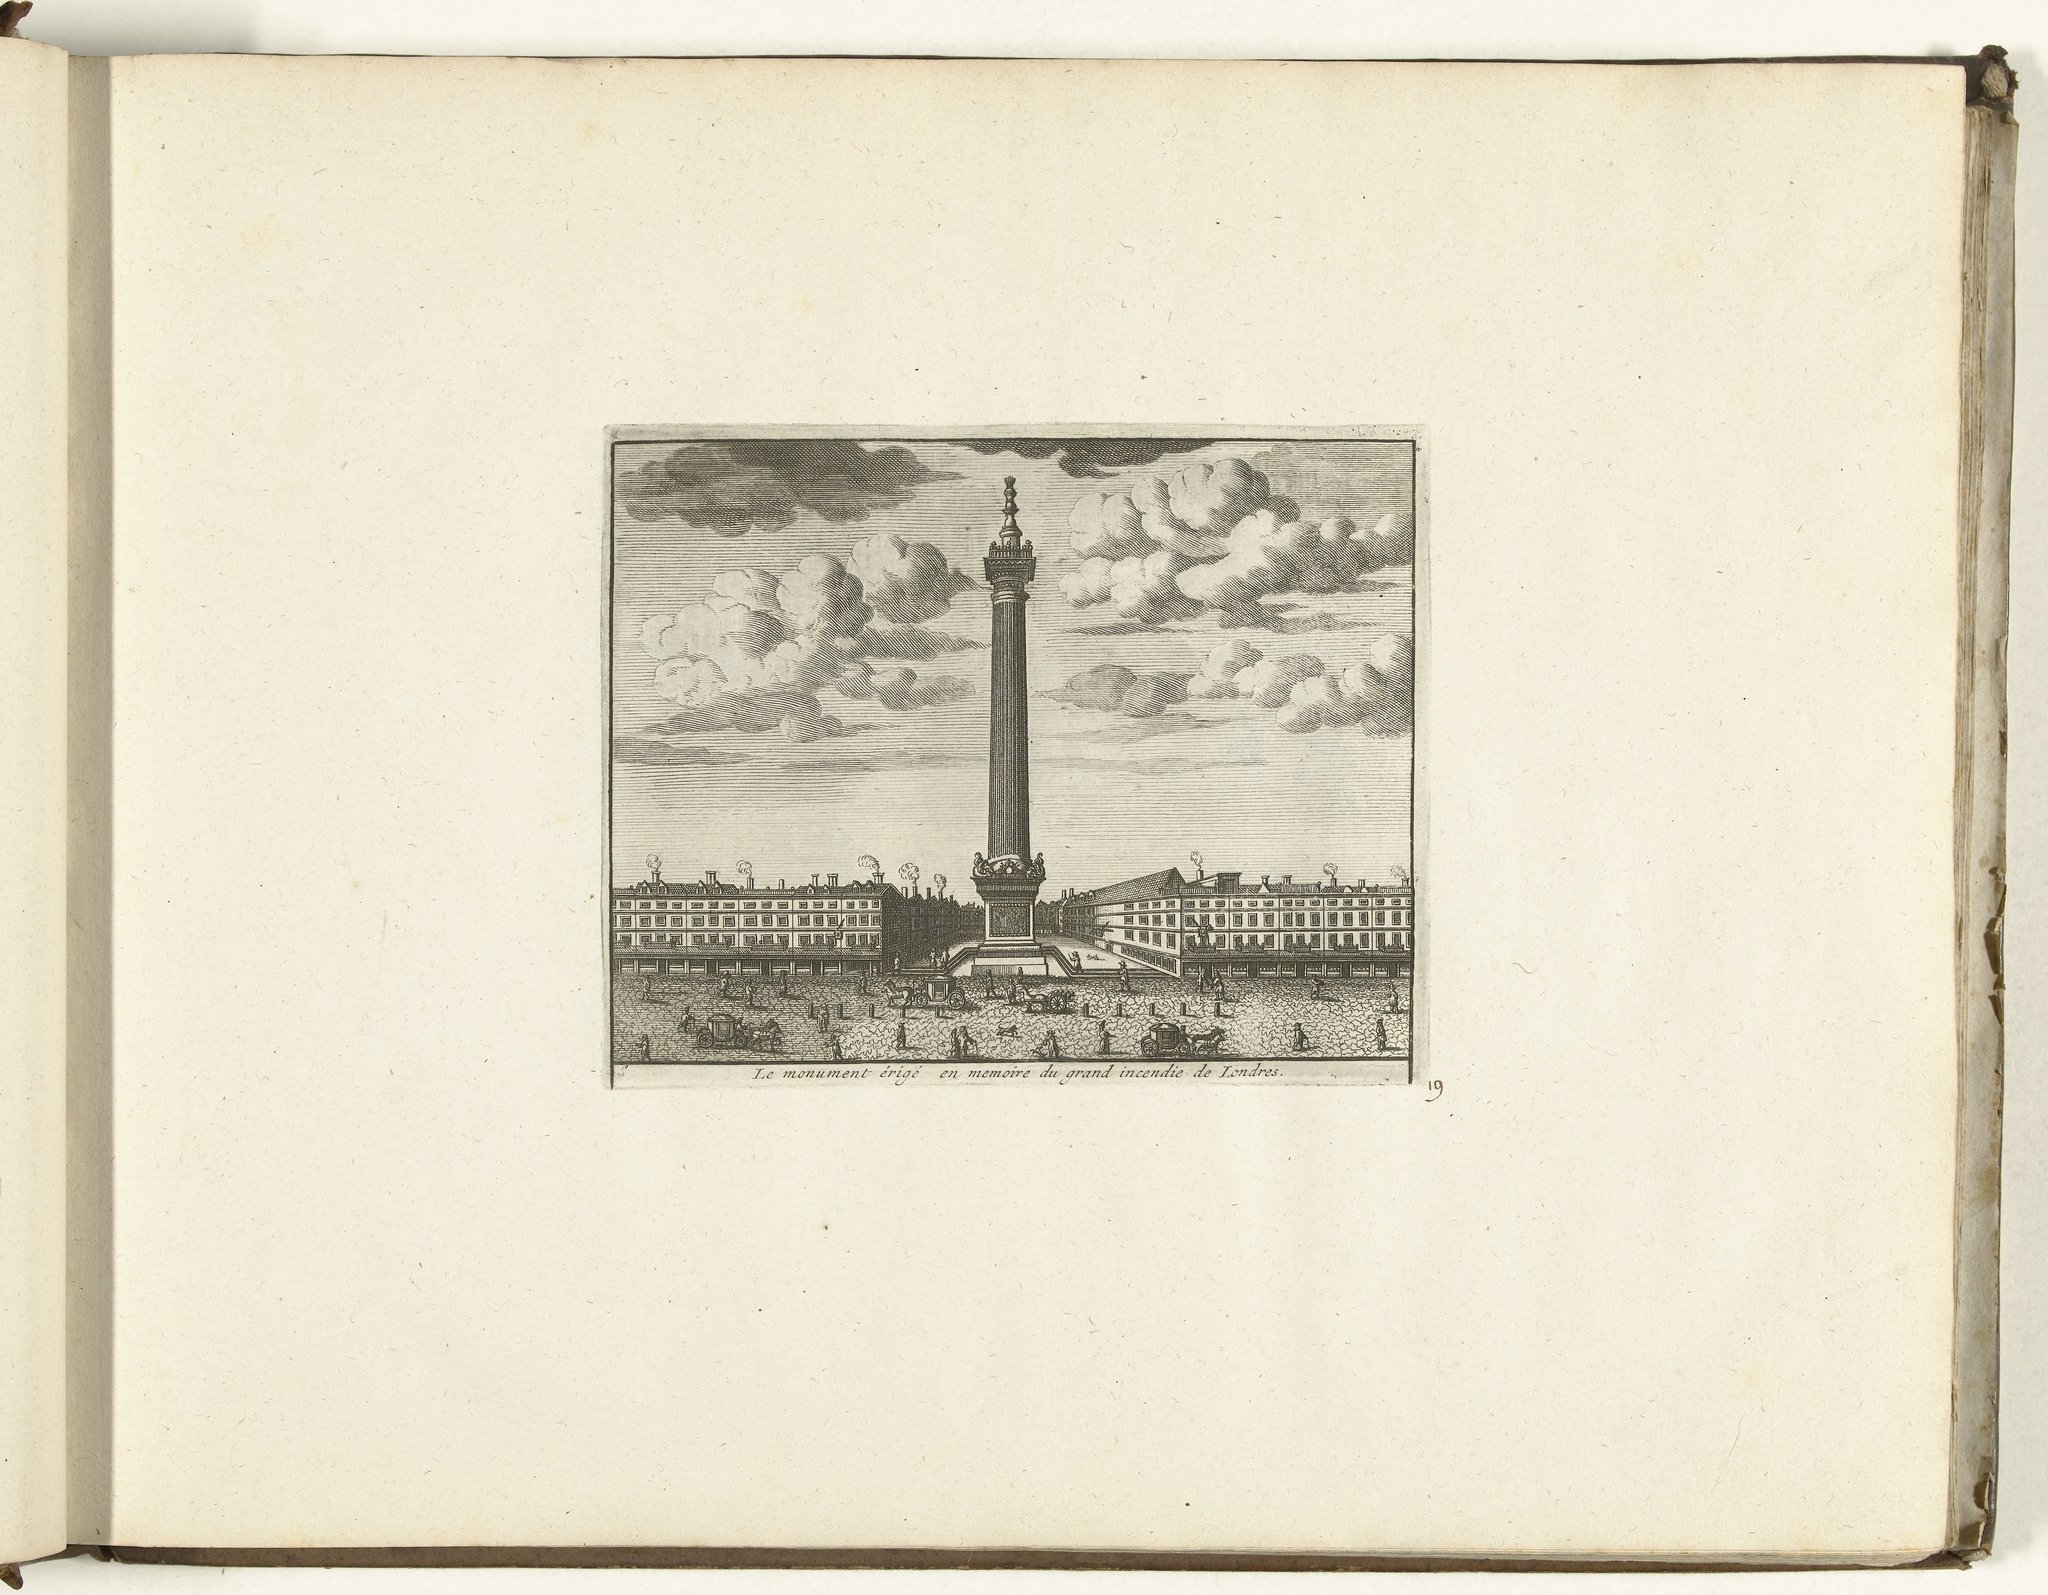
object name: print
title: Les Forces de l'Europe, Asie, Afrique et Amerique (...) Comme aussi les Cartes des Côtes de France et d'Espagne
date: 1726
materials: paper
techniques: etching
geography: northern netherlands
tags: monument to the great fire of london, spaanse successieoorlog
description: Het Monument voor de Grote Brand van Londen in 1666. Plaat nr. 19 in deel I van het prentwerk: Les Forces de l'Europe, Asie, Afrique et Amerique ... Comme aussi les Cartes des Côtes de France et d'Espagne uit 1726, dit eerste deel met 238 met de hand genummerde platen van vermaarde sterke steden en vestingen in het kader van de Spaanse Successieoorlog 1701-1713. Voor het merendeel zijn deze platen gekopieerd naar de anonieme Franse platen van vermaarde sterke steden en vestingen: in Les forces de l'Europe en in: Le theatre de la guerre, dans les Pays-Bas, beide oorspronkelijk uitgegeven door Nicolas de Fer te Parijs (1693-1697) in het kader van de Negenjarige Oorlog. Titel in het Frans.